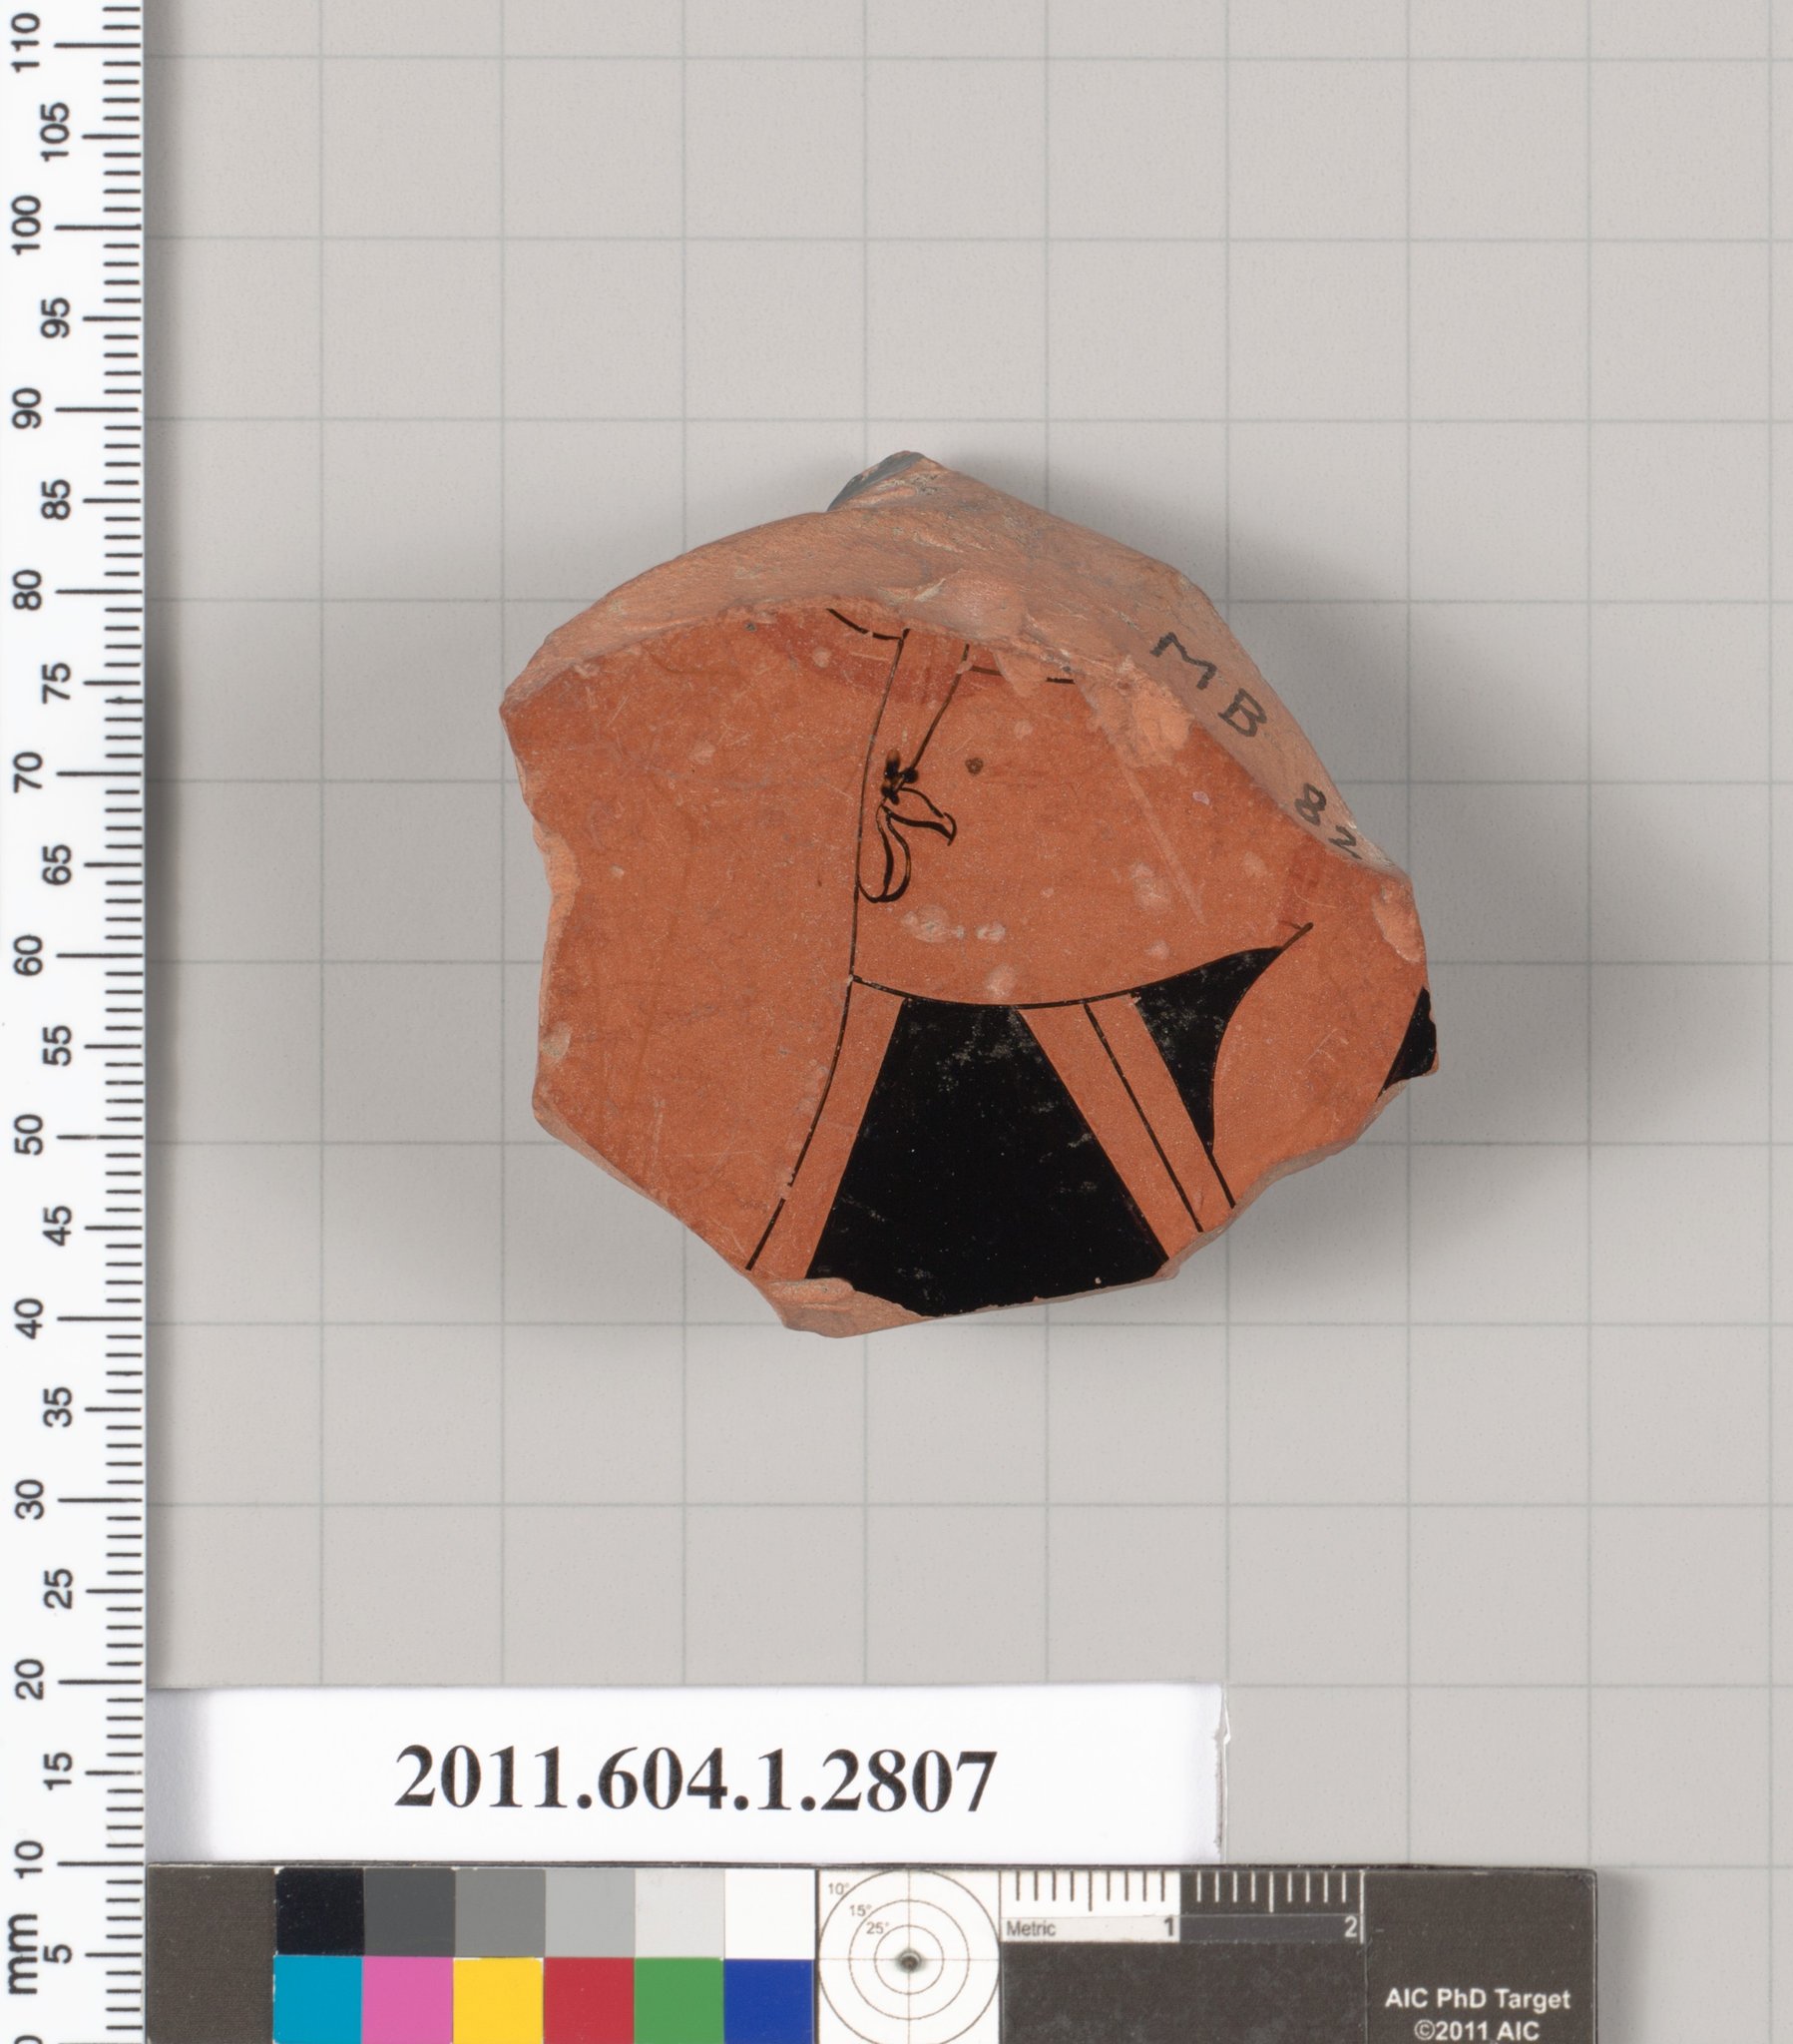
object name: kylix fragment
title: Terracotta fragment of a kylix (drinking cup)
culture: greek, attic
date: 510-490 BCE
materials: terracotta